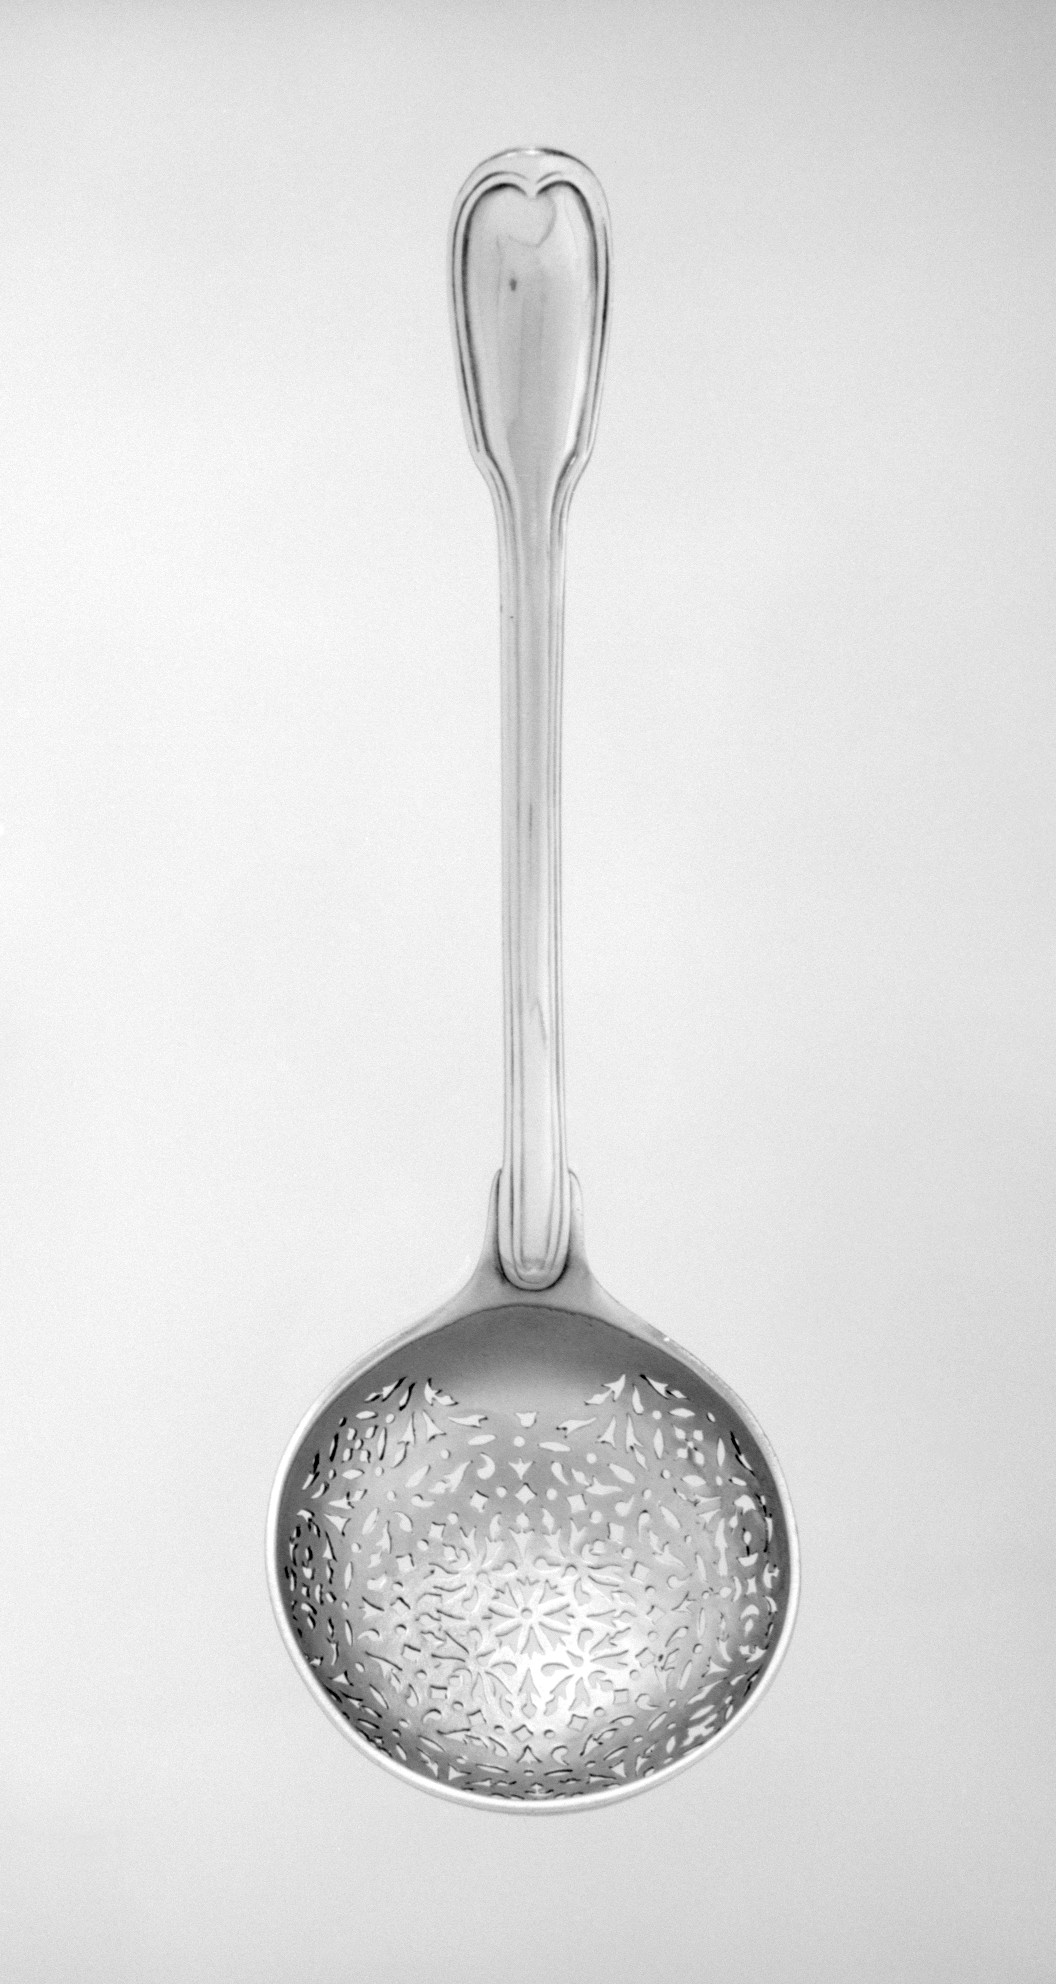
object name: sugar spoon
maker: jean-pierre chézelle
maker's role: maker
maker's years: 1671-1771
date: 1749-1750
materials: gilt, silver